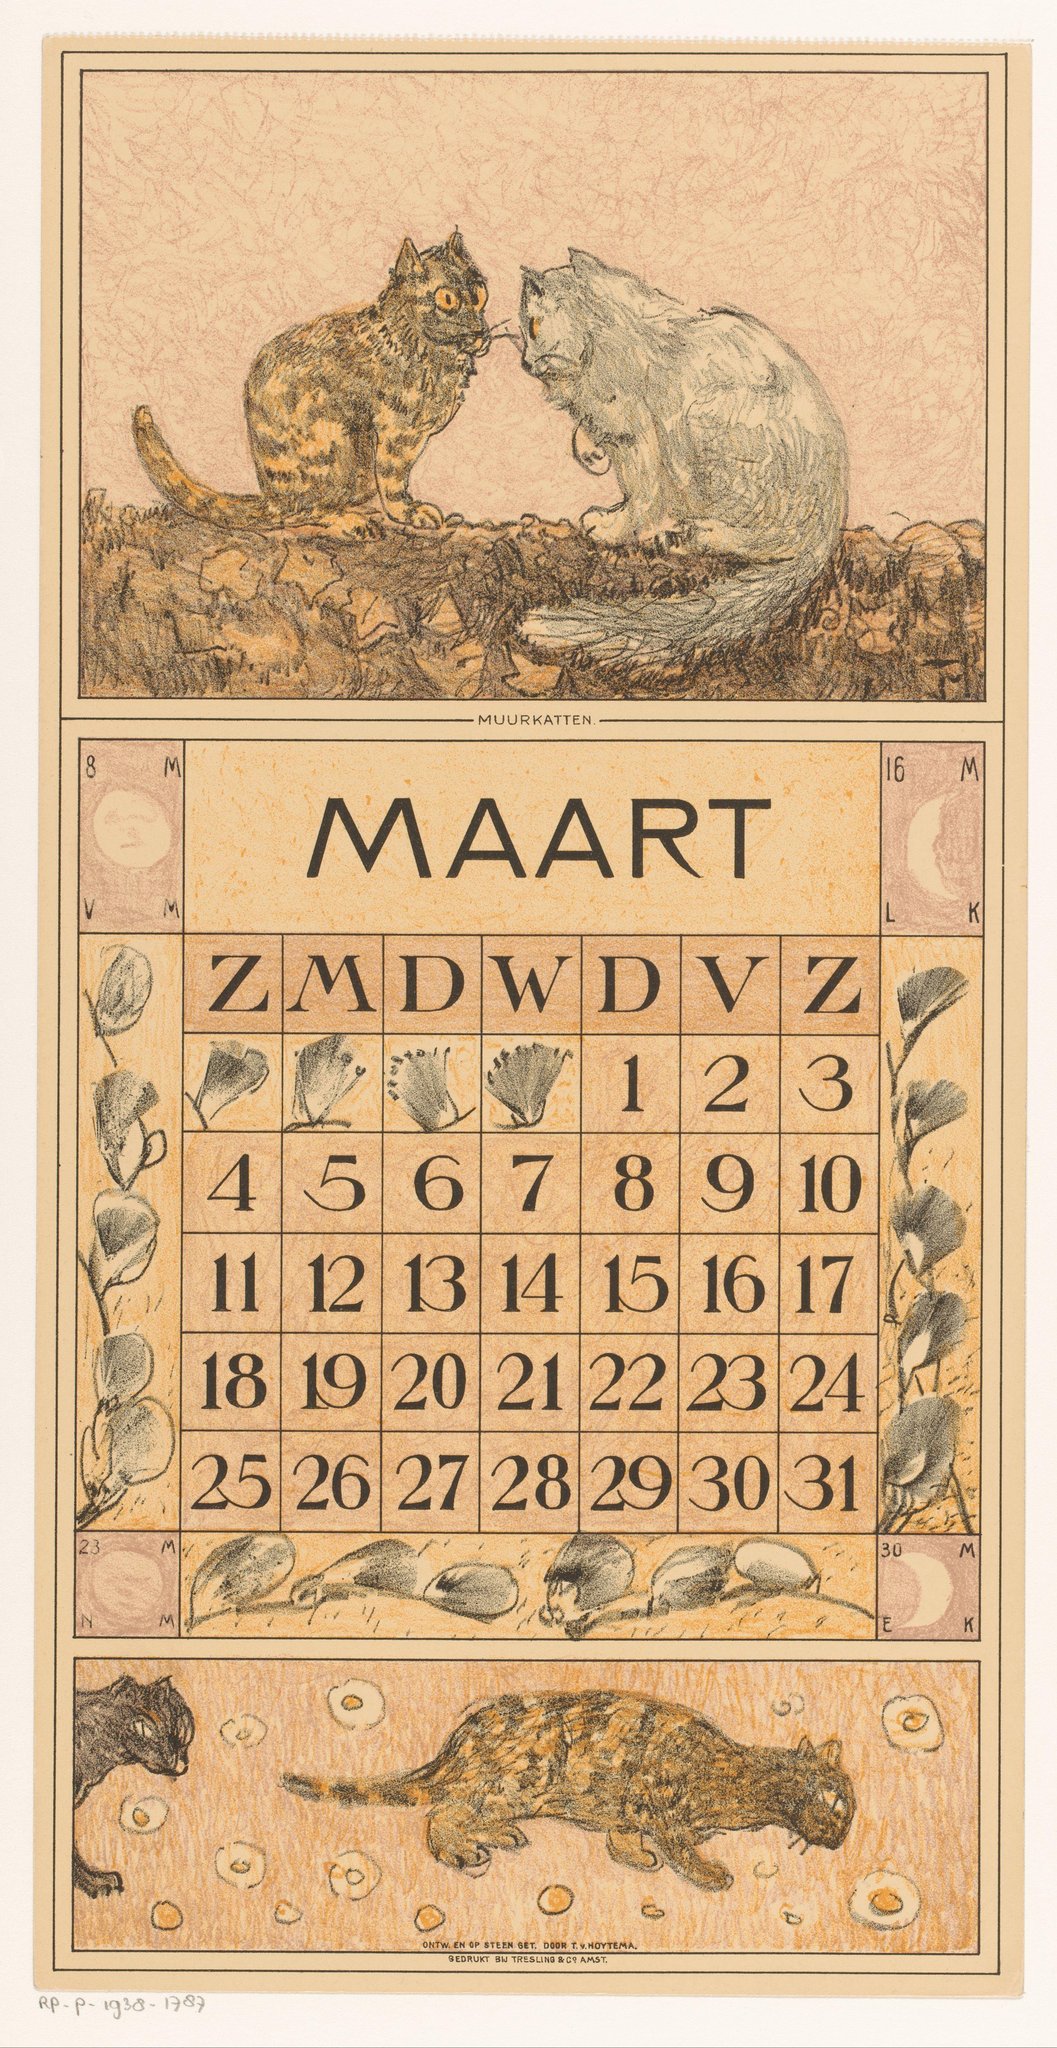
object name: calendar leaf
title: Kalenderblad maart met twee katten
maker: theo van hoytema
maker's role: draughtsman, painter, print maker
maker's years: 1863-1917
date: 1916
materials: paper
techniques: lithograph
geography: amsterdam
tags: cat, lunar year, fence, wall, paling, march ~ other concepts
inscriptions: collector's mark: Lugt 2228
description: De katten zitten op een muur. Onderin twee katten. In de hoeken de standen van de maan op vier dagen. Bovenaan het blad een scheurlijn.